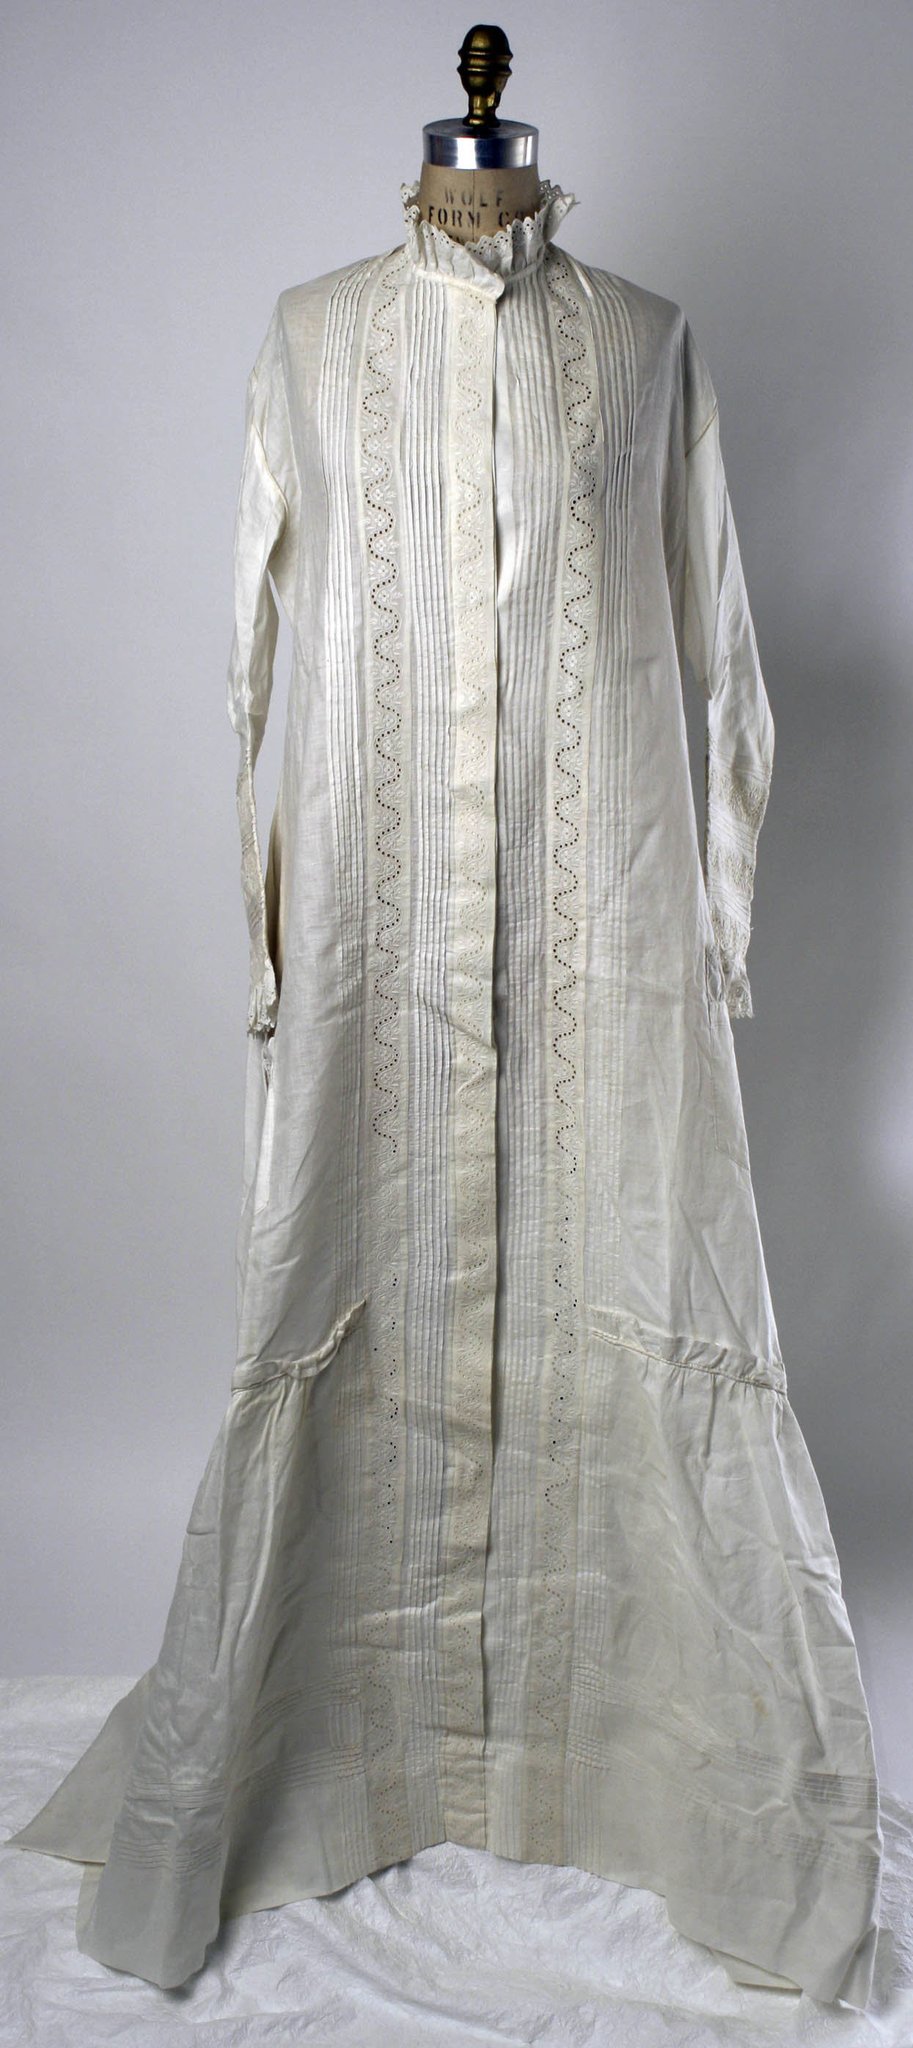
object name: negligée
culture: american or european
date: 1870-1879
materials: cotton